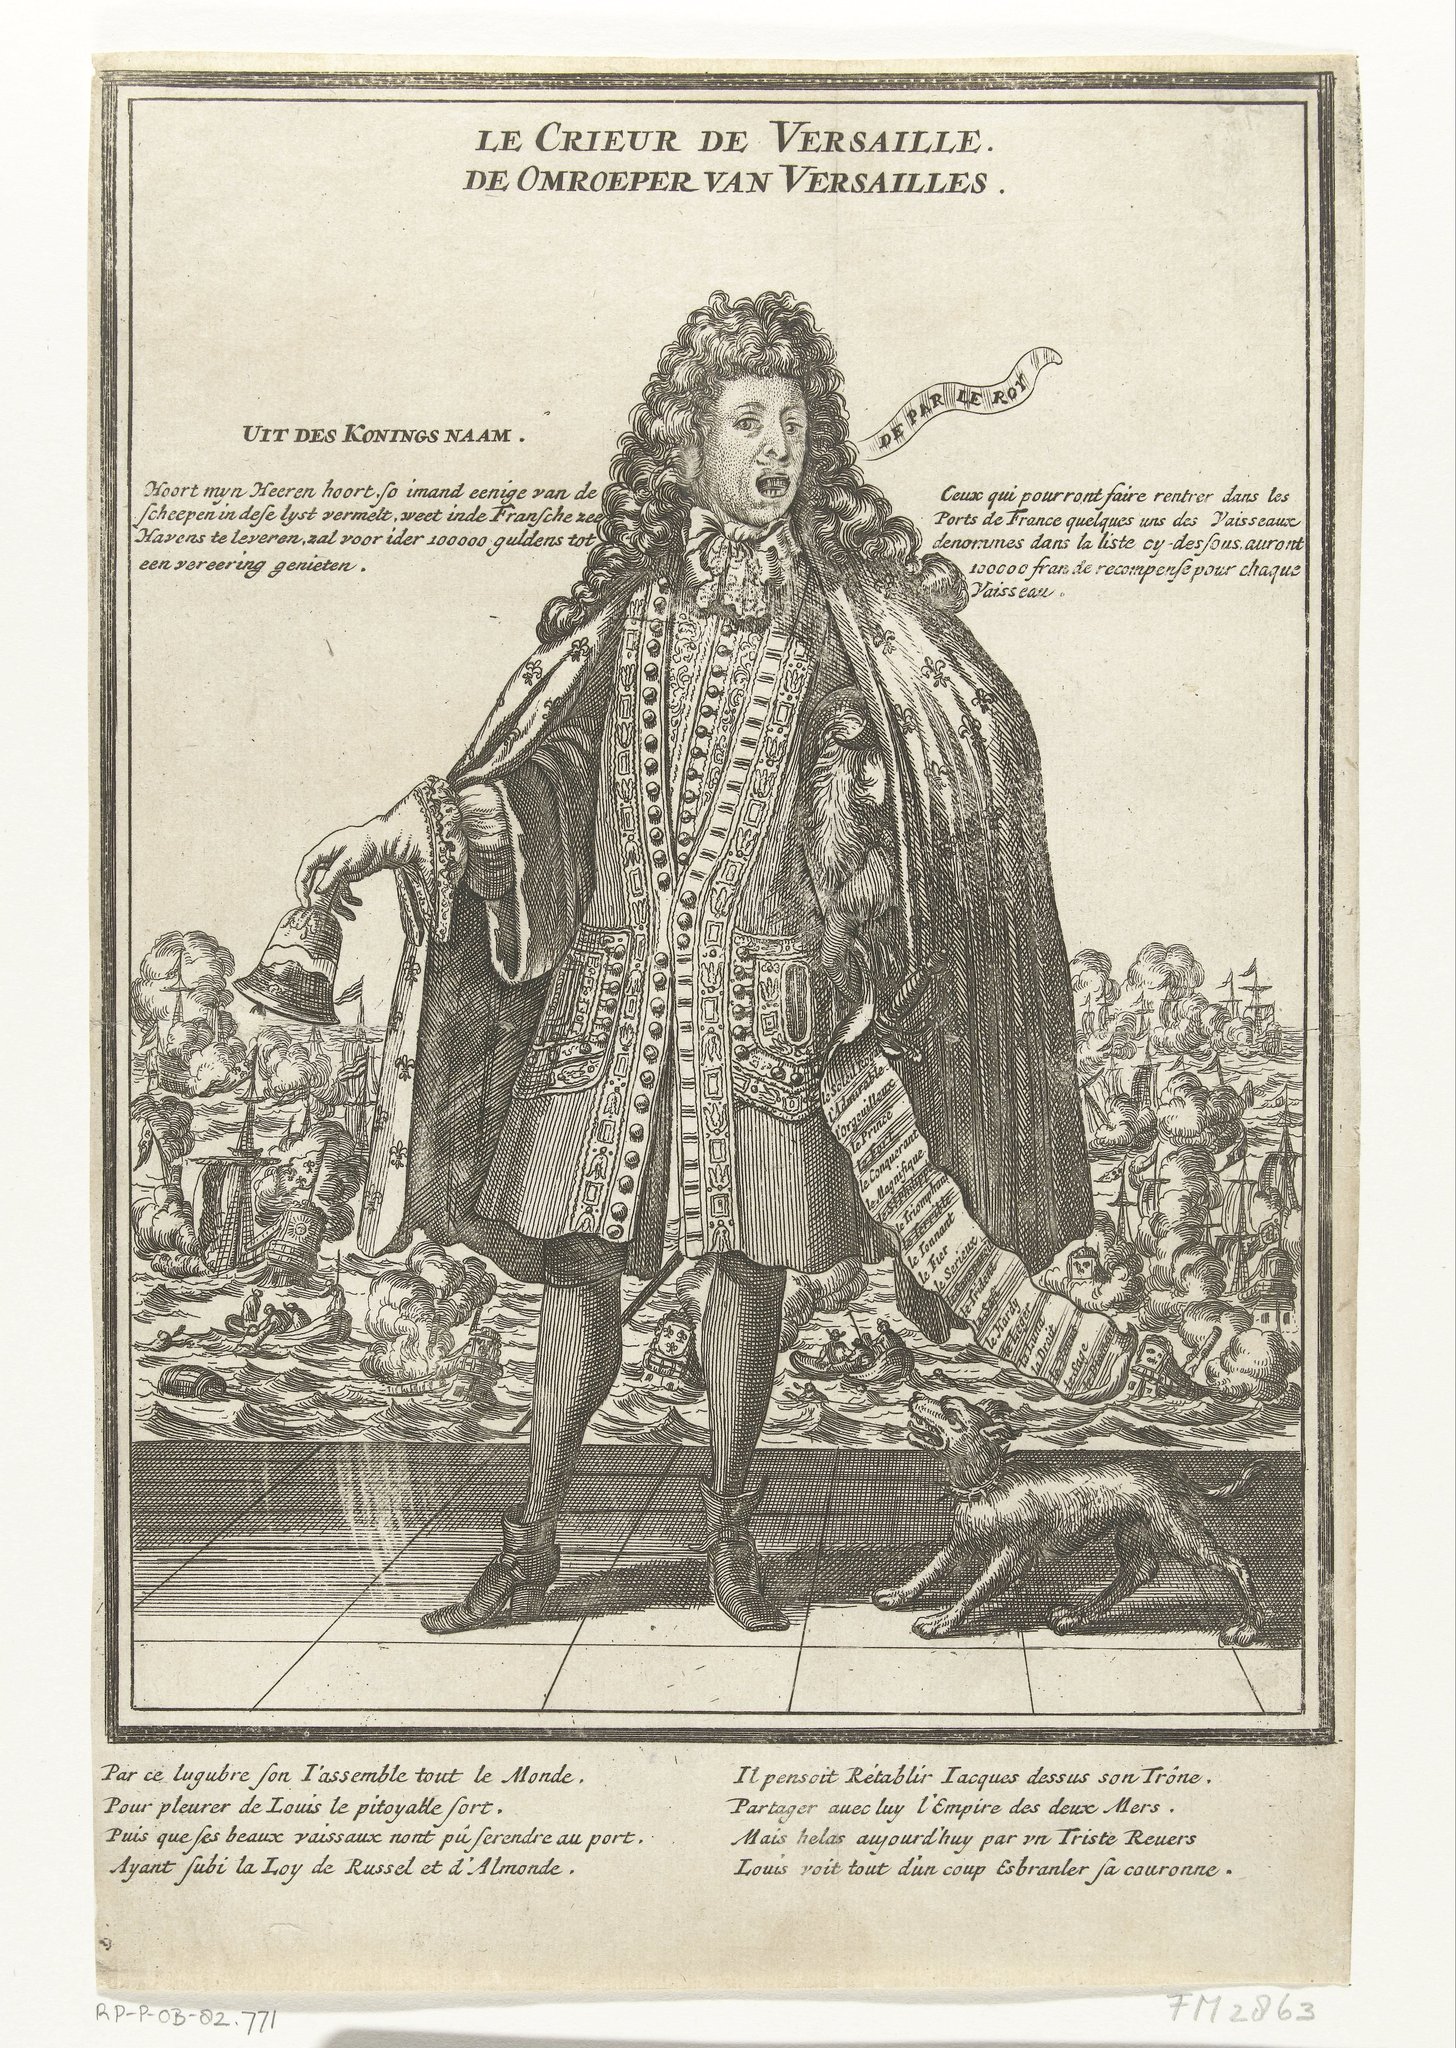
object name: print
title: Le Crieur de Versaille / De Omroeper van Versailles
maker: Anonymous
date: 1692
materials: paper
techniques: etching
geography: northern netherlands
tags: lodewijk xiv (koning van frankrijk), paris, battle (+ naval force), oral spreading of news, town crier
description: De Omroeper van Versailles. Spotprent op de Franse koning Lodewijk XIV die als een stadsomroeper het nieuws brengt van de nederlaag in de zeeslag bij Kaap la Hogue waarbij de Fransen onder admiraal de Tourville werden verslagen door de gecombineerde vloot van Engeland en Holland onder de admiralen Russel en Almonde, 29 mei t/m 3 juni 1692. In de rechterhand een schel, in de linkerhand een lange lijst met de namen van de verbrande Franse schepen, bij zijn voeten een blaffend hondje, op de achtergrond de zeeslag. In de voorstelling een oproep uit naam van de koning in het Nederlands en Frans, onderaan twee verzen van vier regels in het Frans.